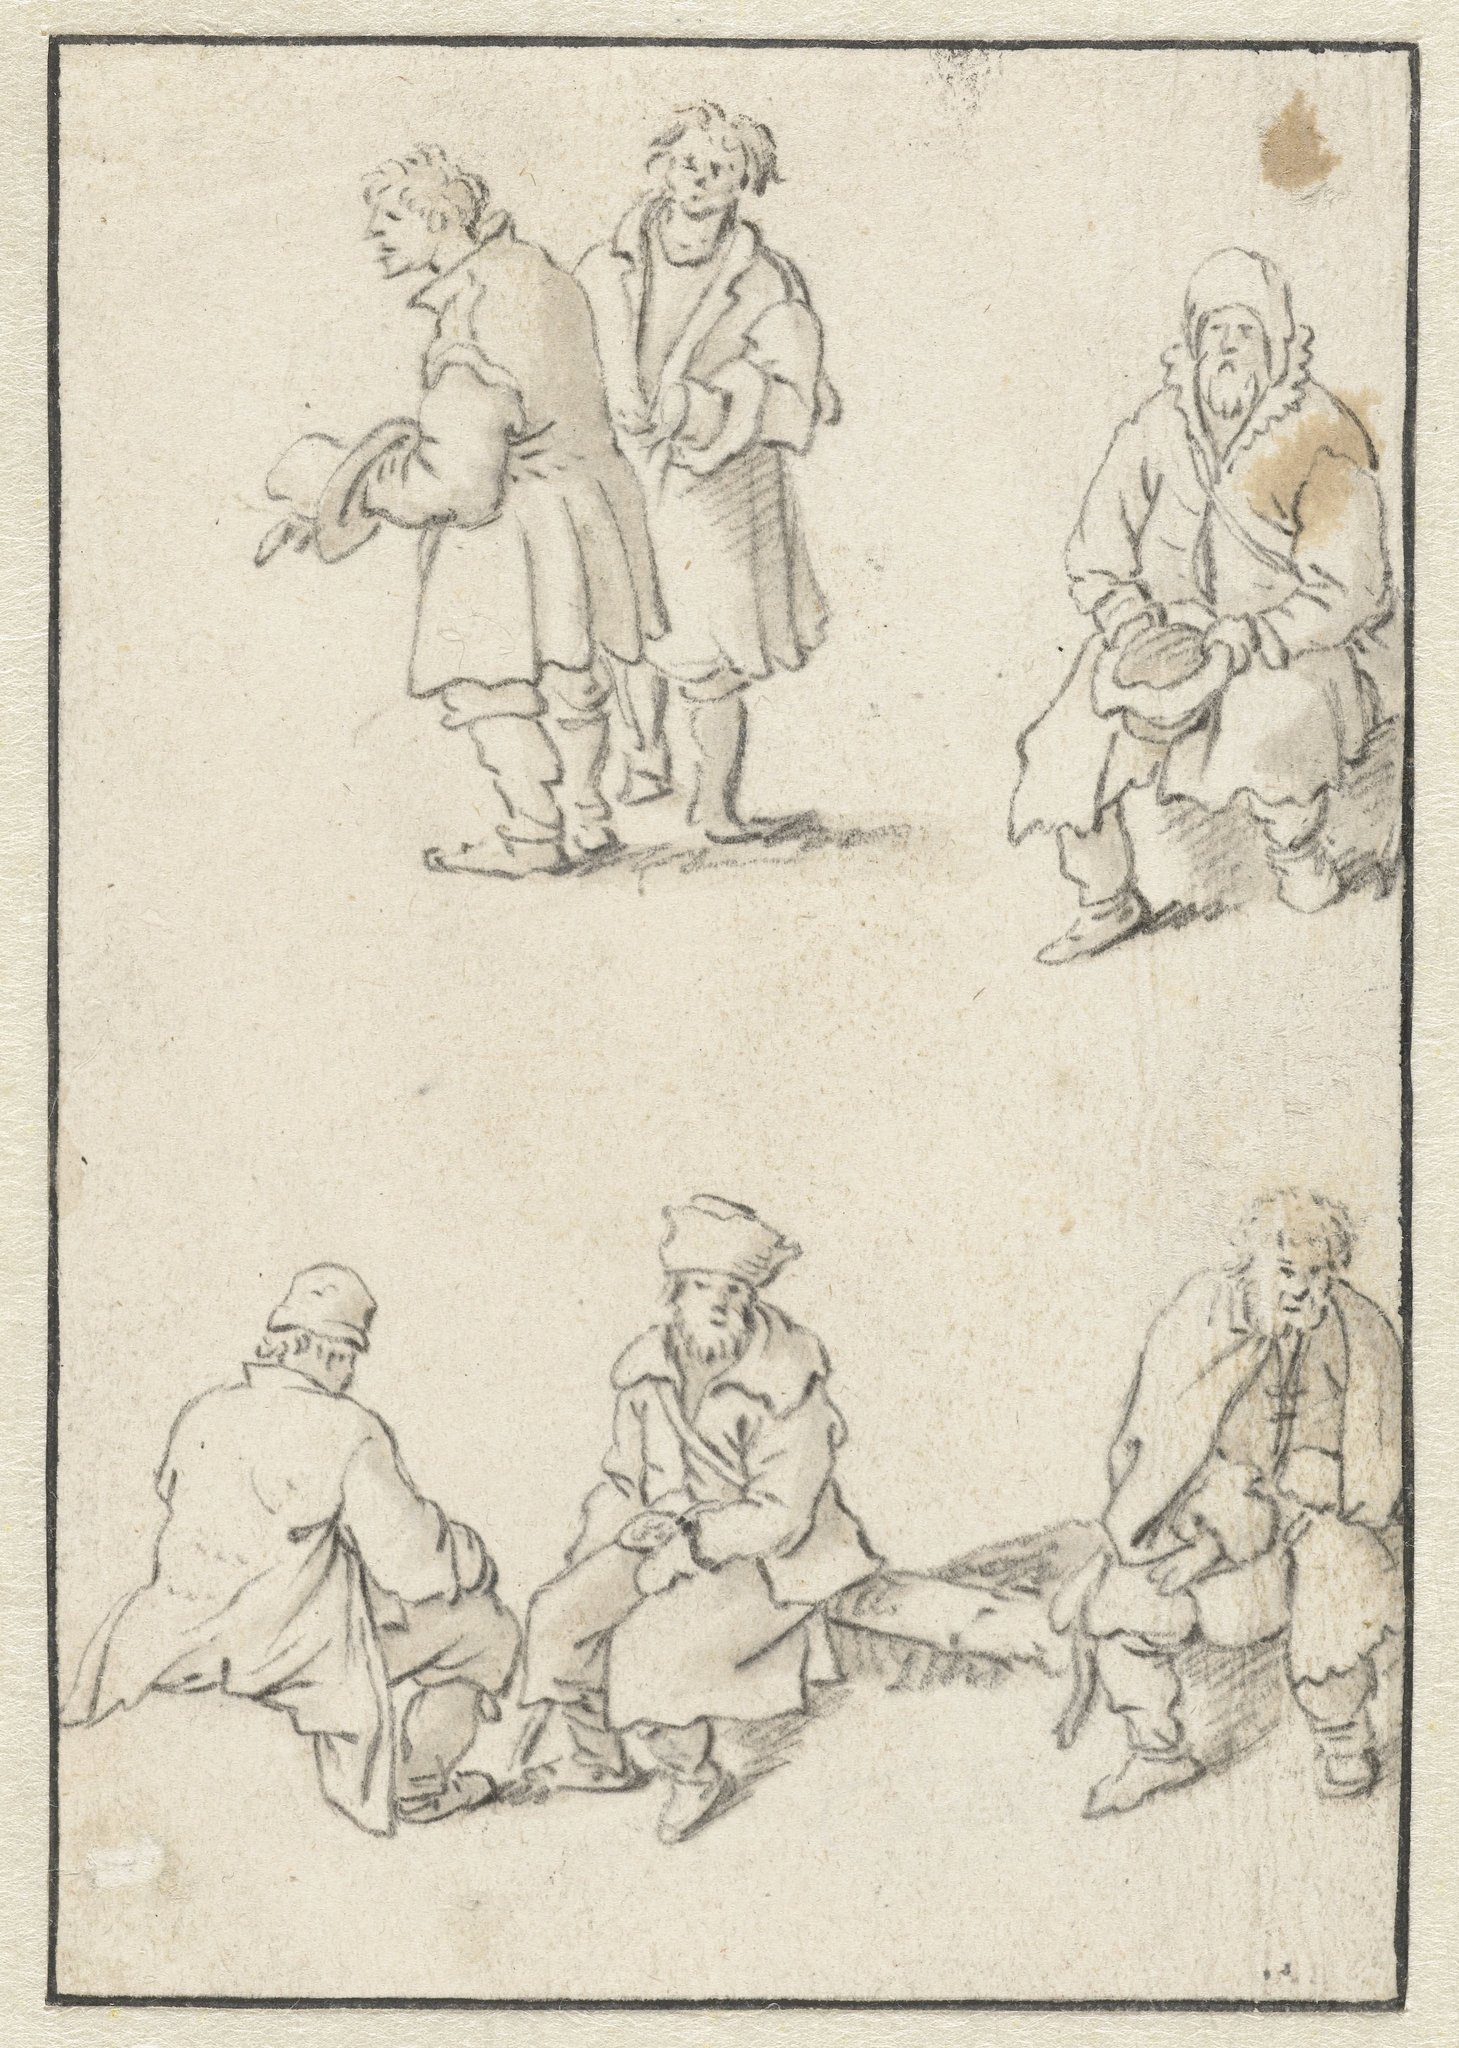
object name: drawing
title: Twee staande en vier zittende mannen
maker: herman saftleven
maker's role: draughtsman, painter, print maker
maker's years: 1609-1685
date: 1619-1685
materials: chalk, paper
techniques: brush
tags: standing figure, sitting figure